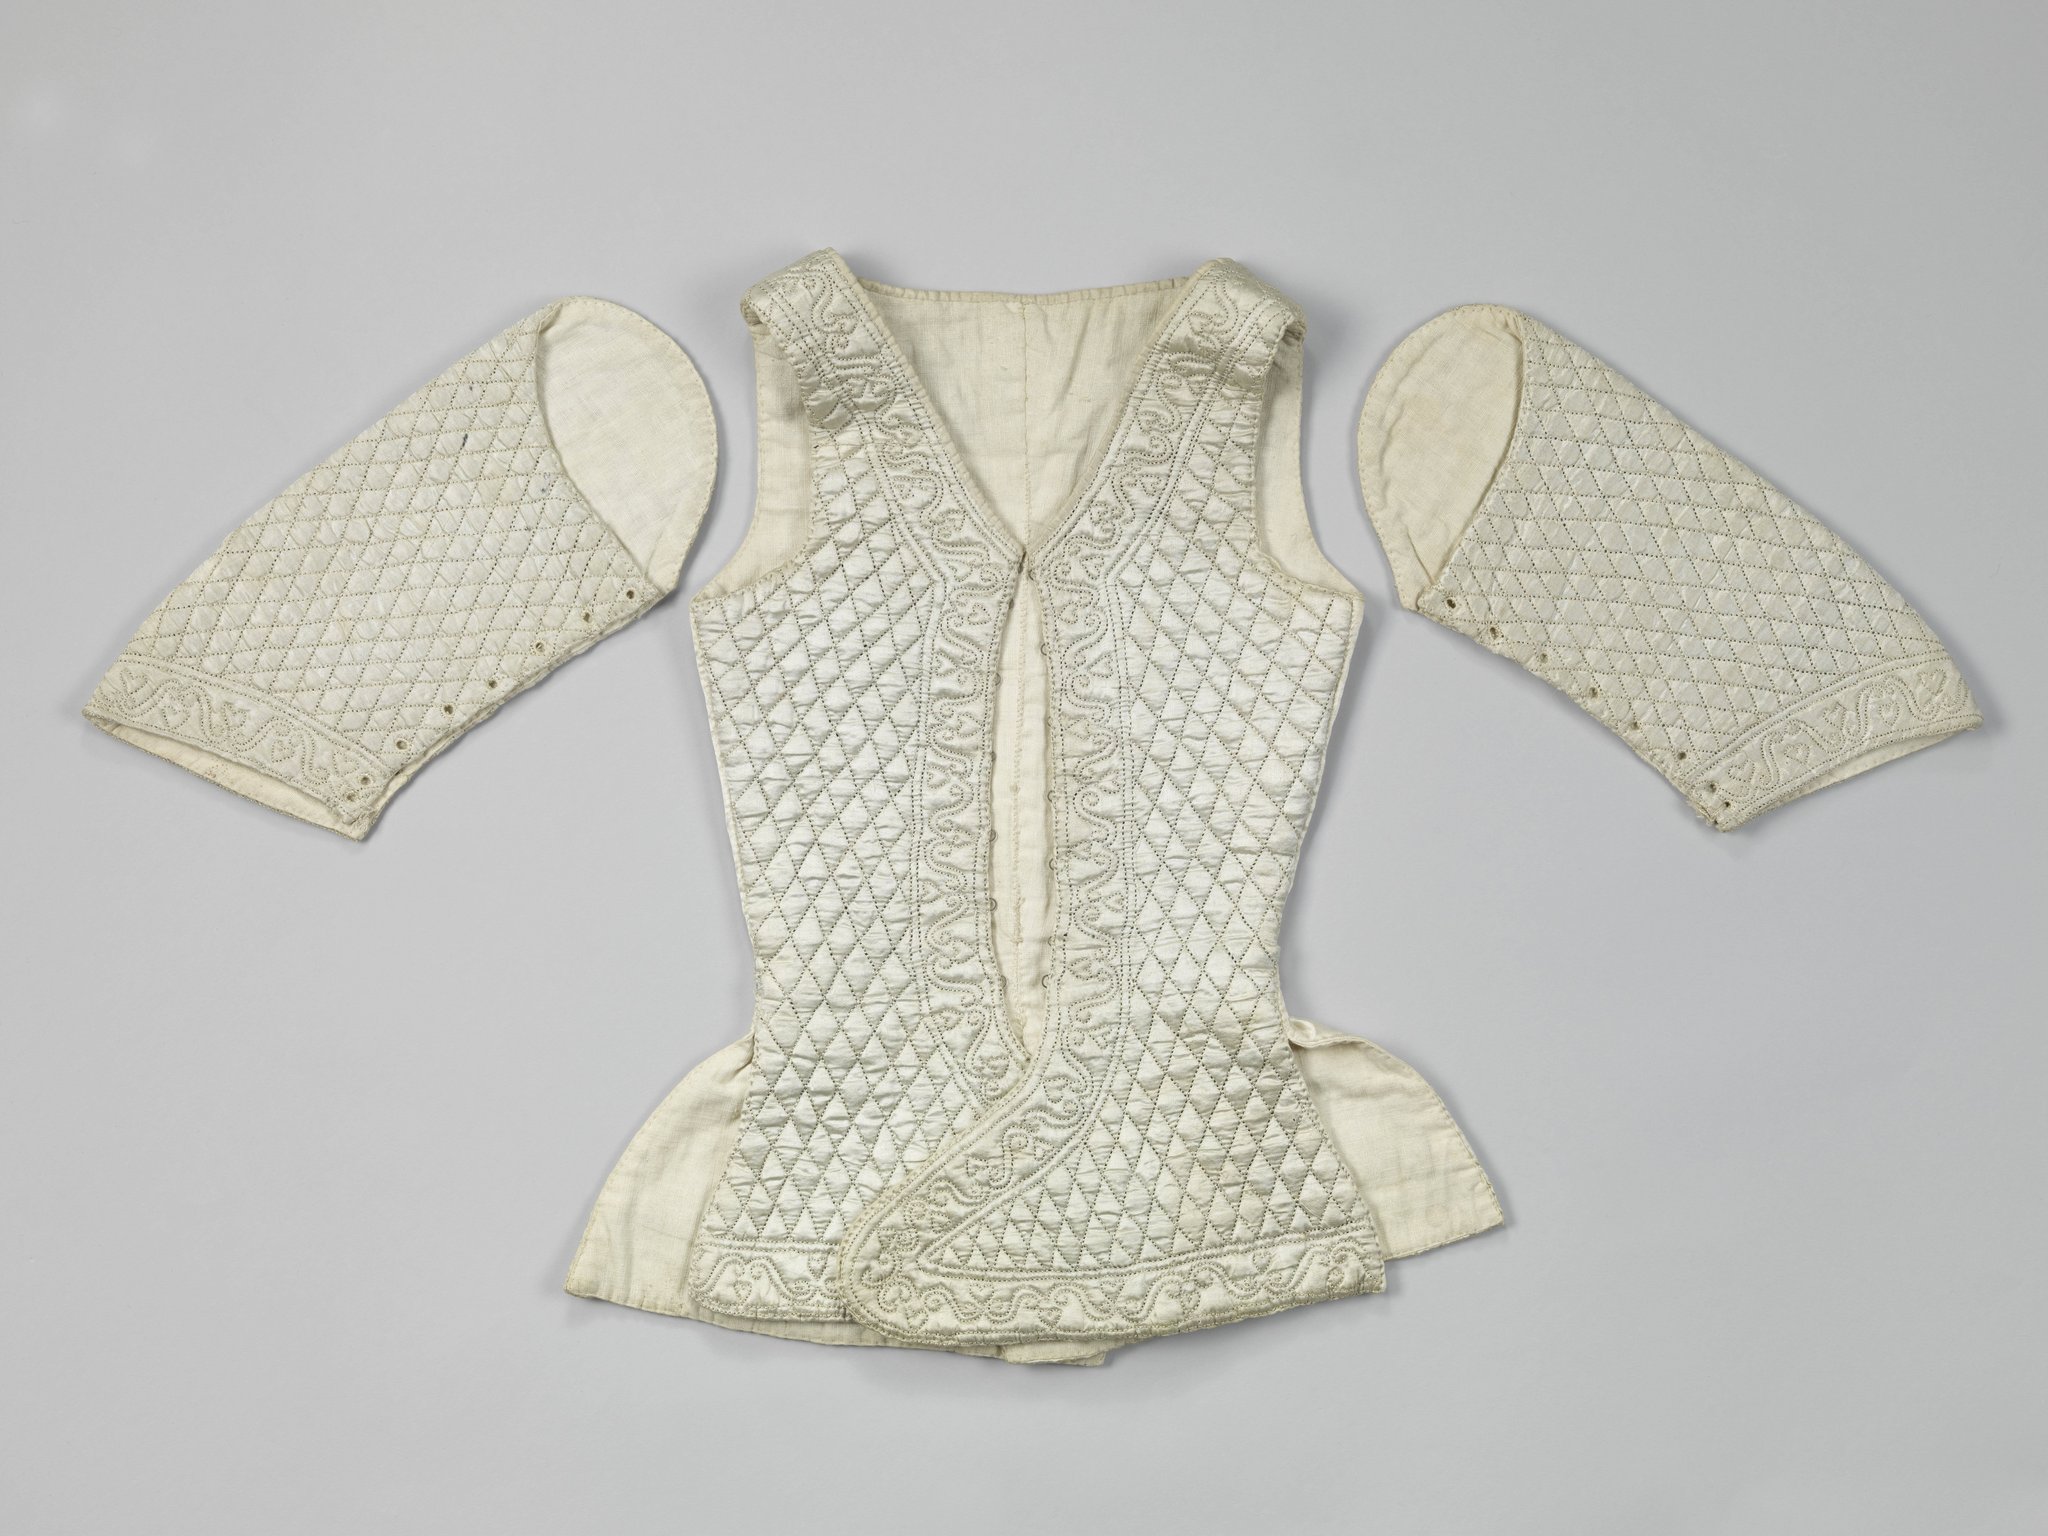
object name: childrenswear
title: jump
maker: Anonymous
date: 1690-1750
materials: textile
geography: netherlands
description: Lijfje met aangeknipte schoot en losse mouwen van doorgestikt satijn. De naad midden op de rug is aan de binnen- en buitenkant verstevigd met gefestonneerde trenzen. Hierdoor wordt de mogelijke spanning door het aantrekken van de vetersluiting aan de voorkant gecompenseerd en voorkomen dat de rugnaad open zou springen. De naad is aan de binnenkant met grove (nieuwe?) steken dichtgenaaid en dit zou kunnen wijzen op een 'ongelukje' in het verleden. Een 'hongerlijn' is een kledingstuk met mouwen, getailleerd en 'met breede panden neerwaarts hangende'. In 1710 (F. Halma, Woordenboek der Nederduitsche en Fransche Talen) is een 'corset, 'een gestikt lyfje zonder balynen'.